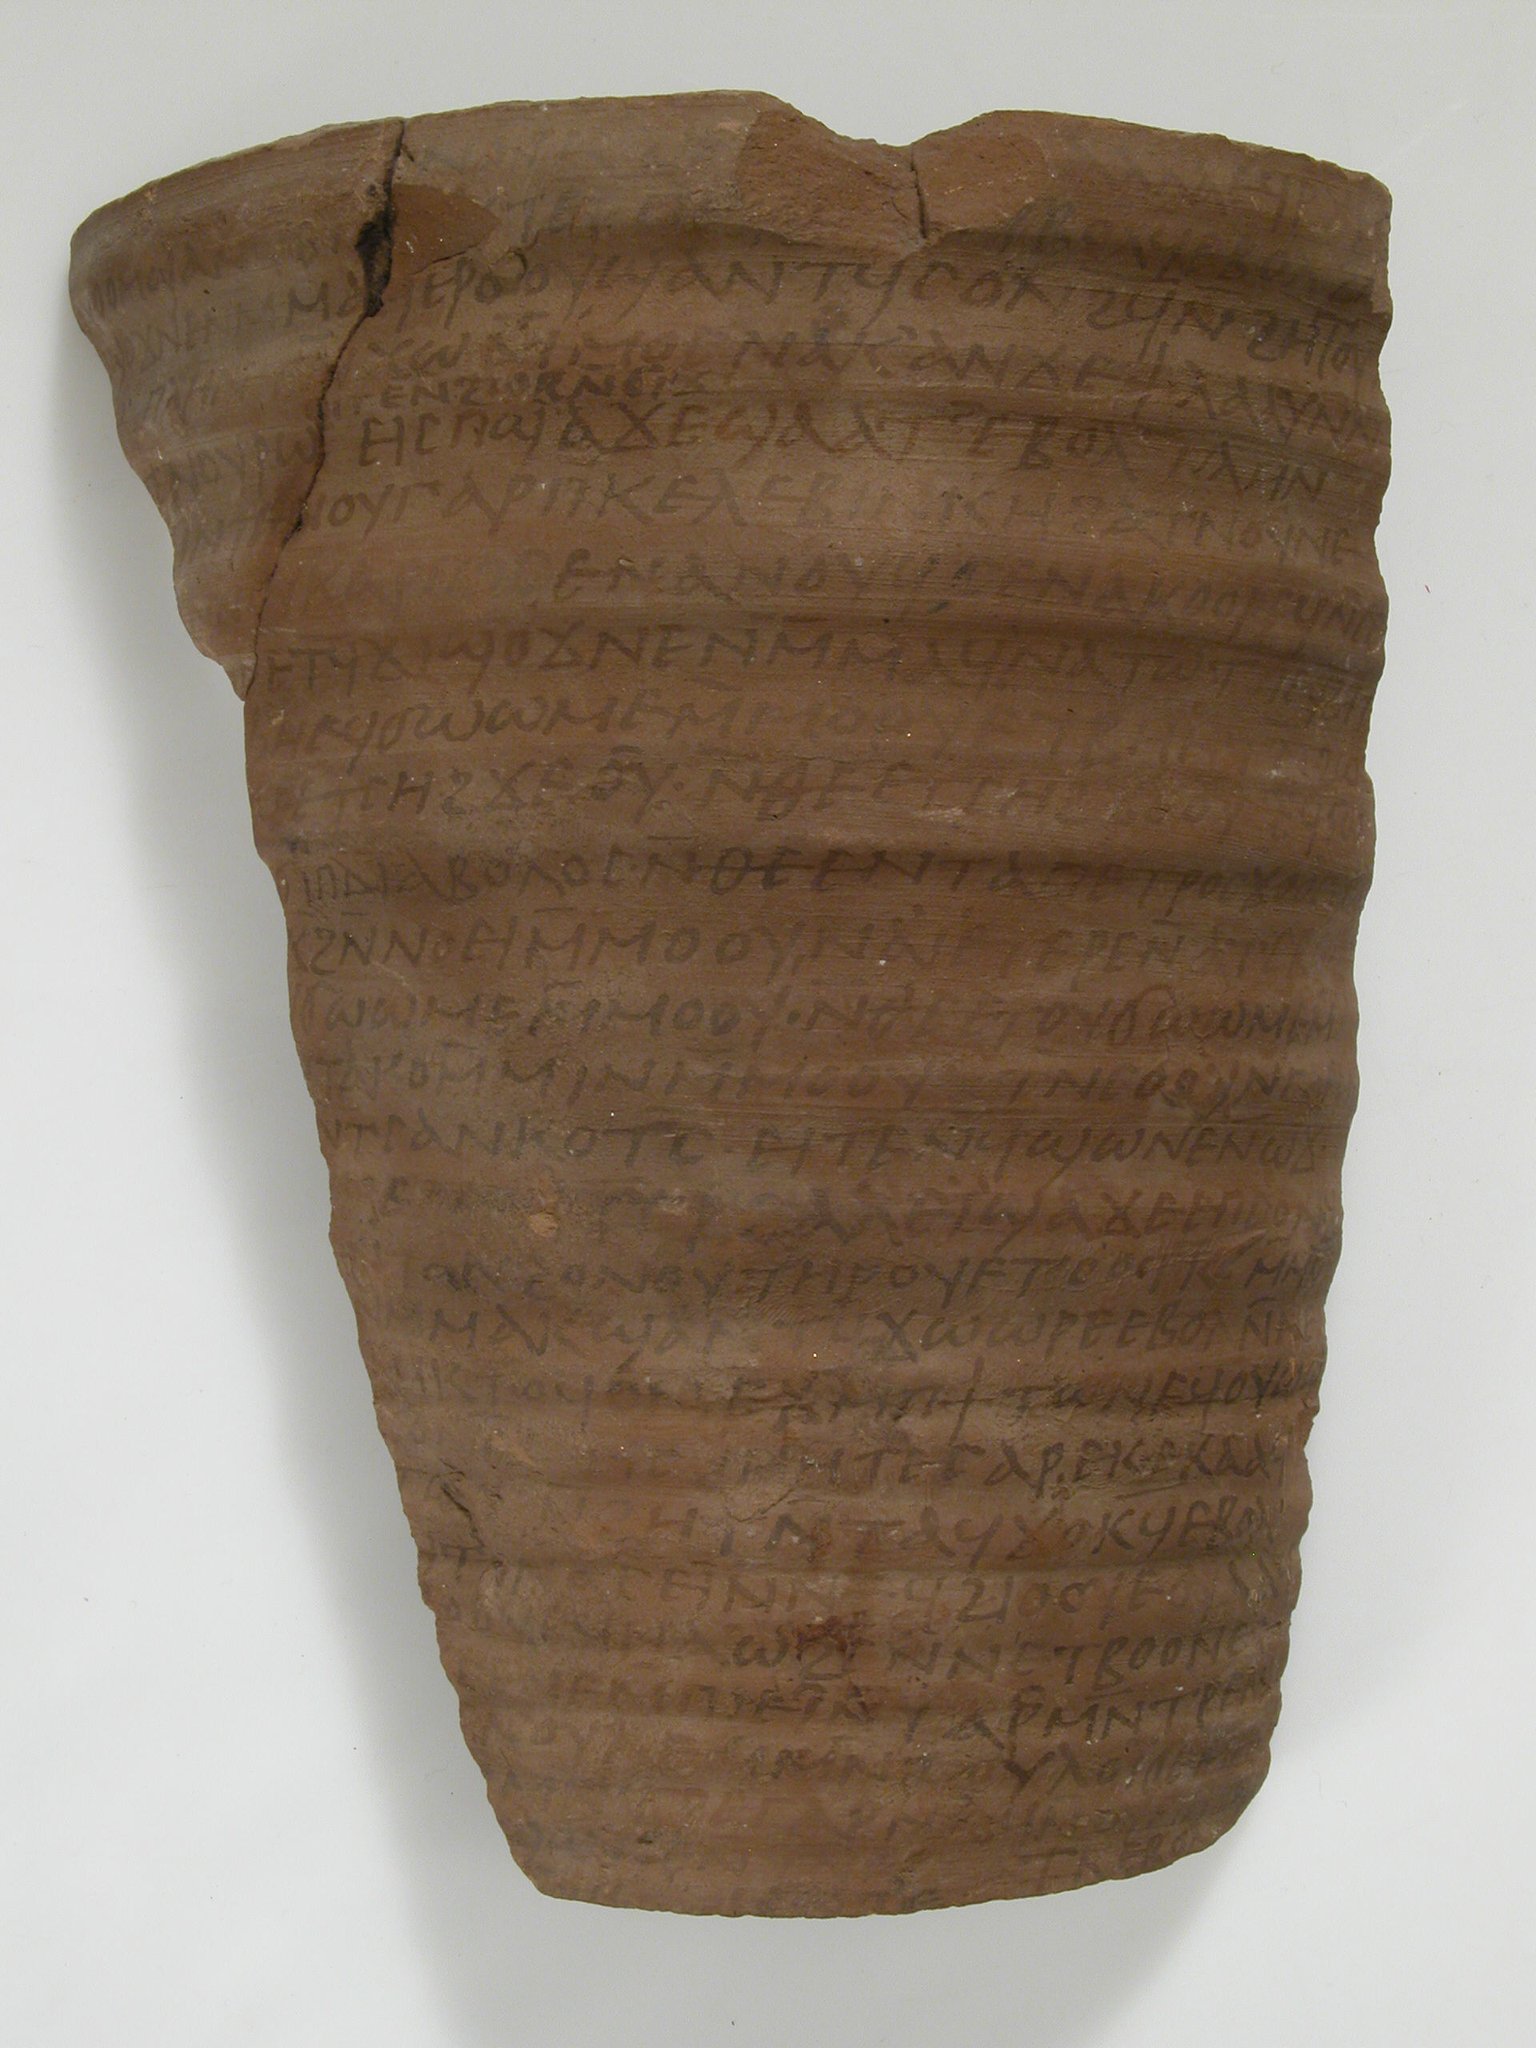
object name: ostrakon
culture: coptic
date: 601-700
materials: ink, pottery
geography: egypt